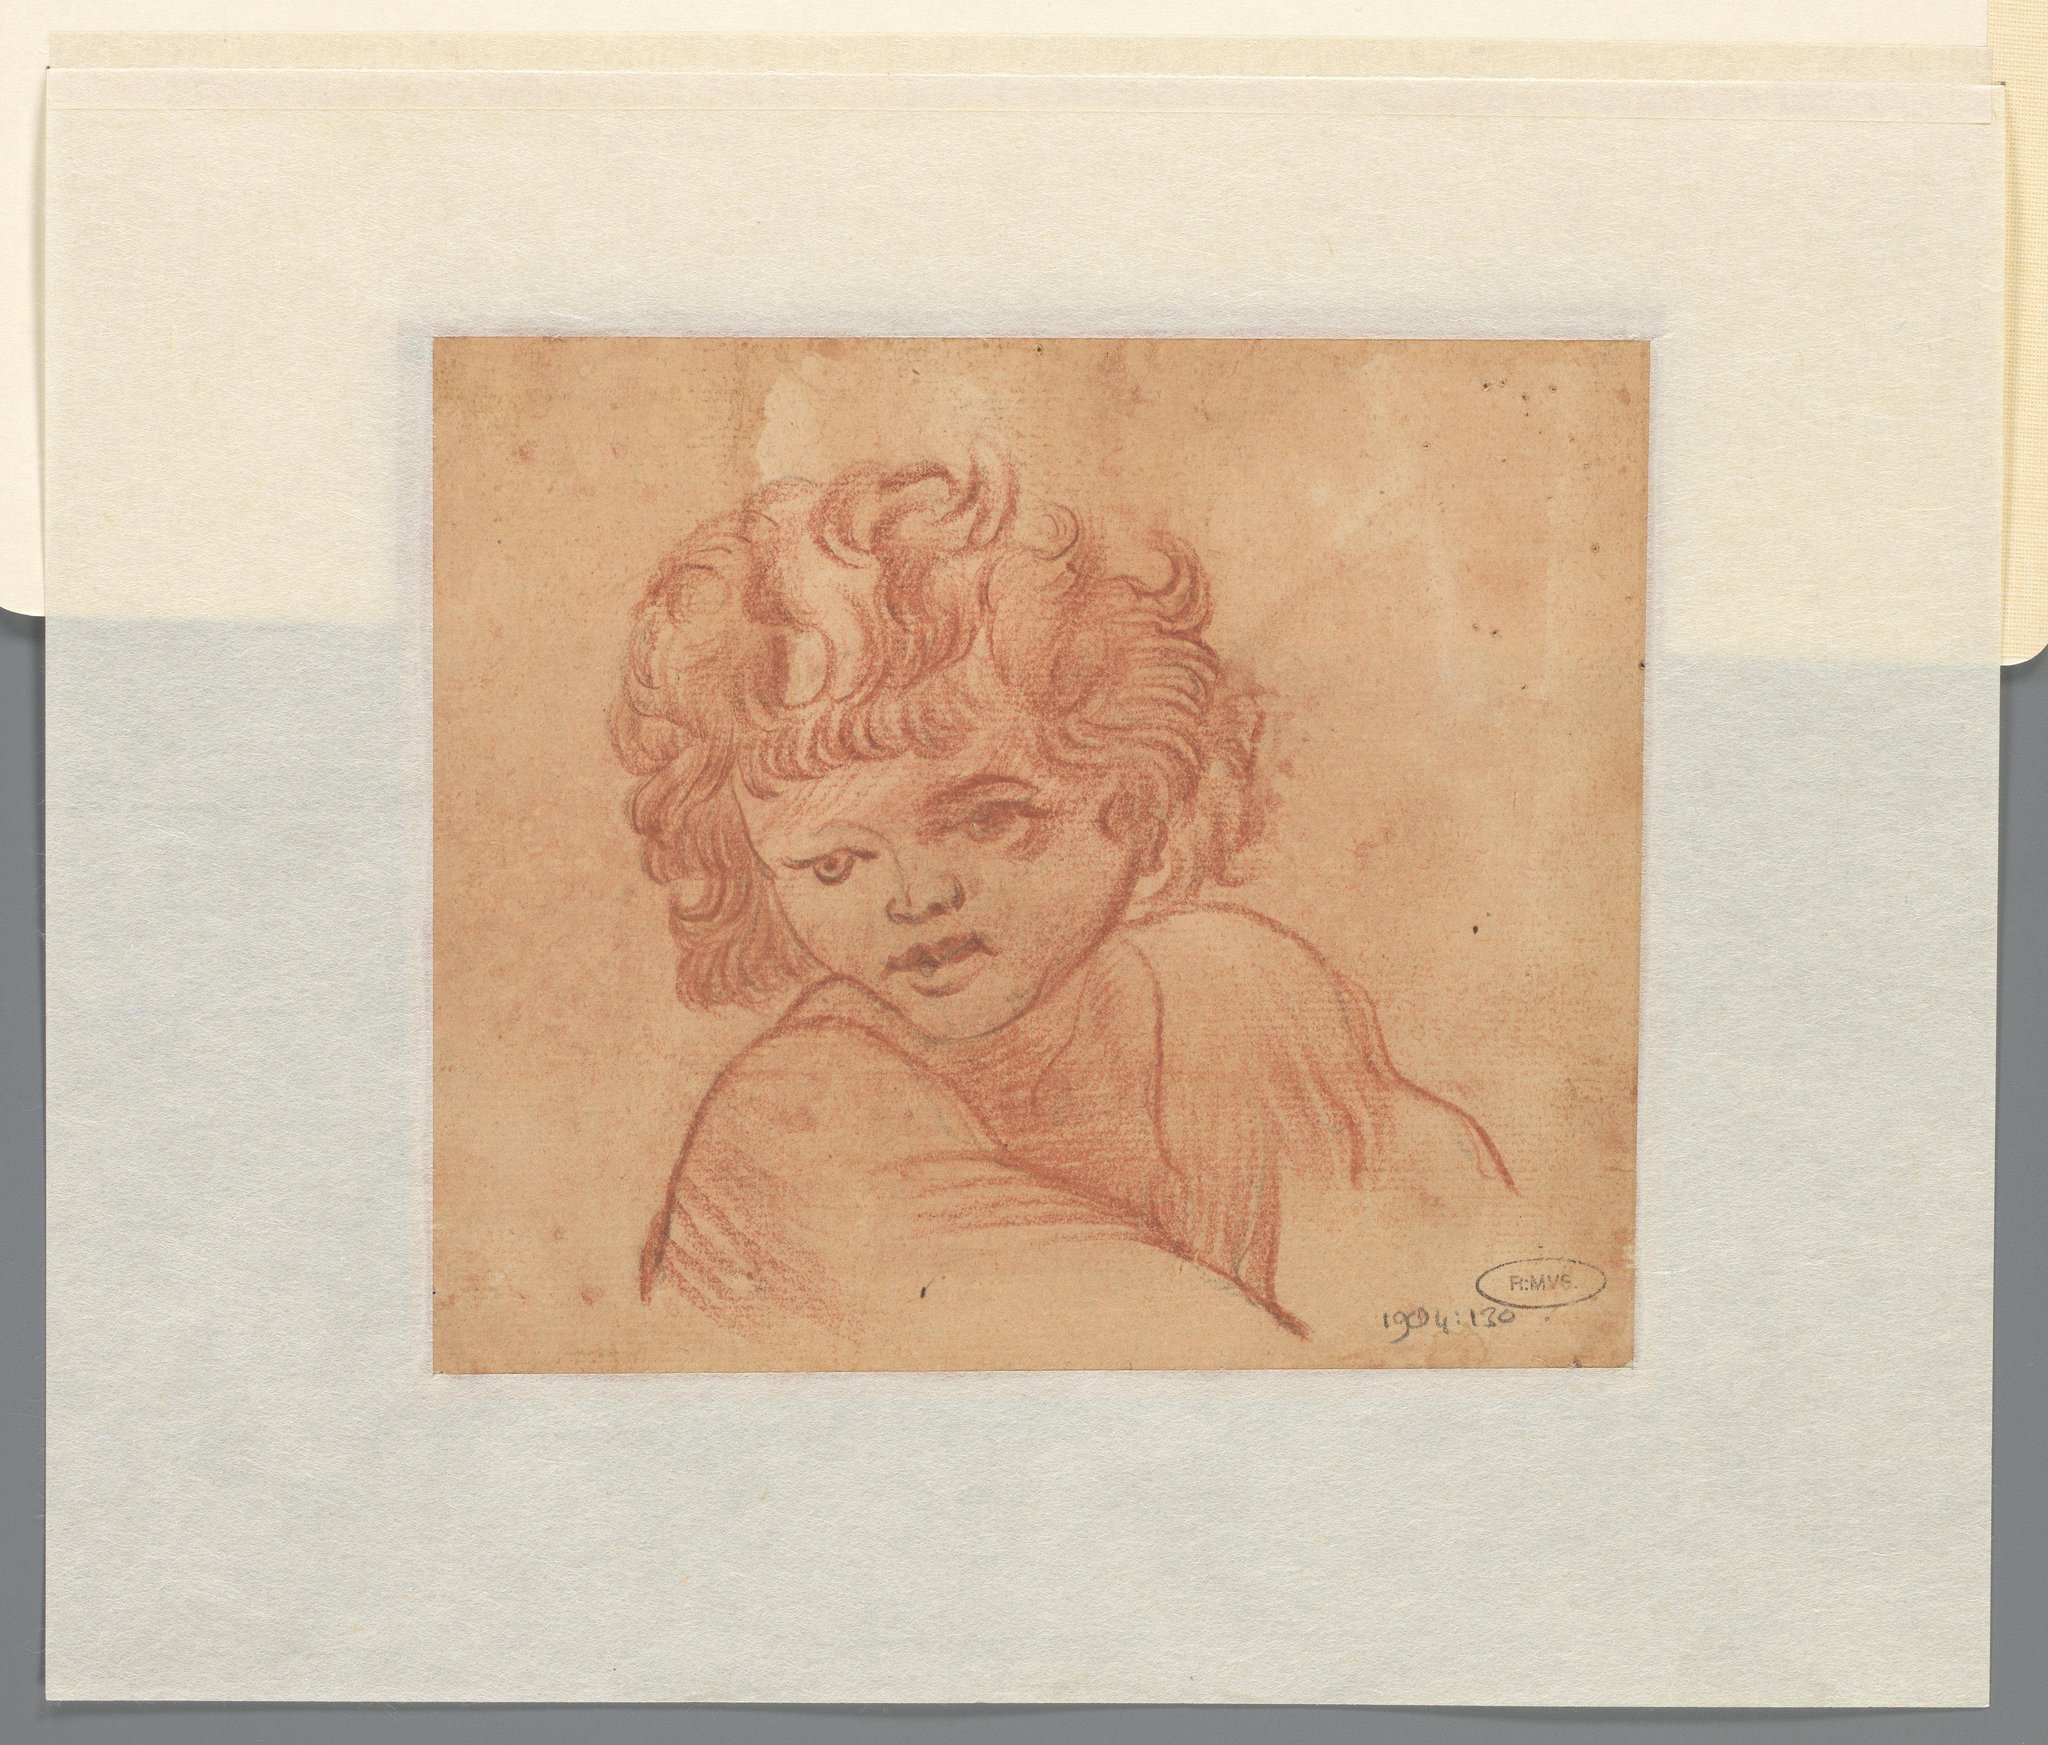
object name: drawing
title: Kinderkopje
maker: jan anton garemyn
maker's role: draughtsman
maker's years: 1712-1799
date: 1769-1789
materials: chalk, paper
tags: head (human), child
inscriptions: date